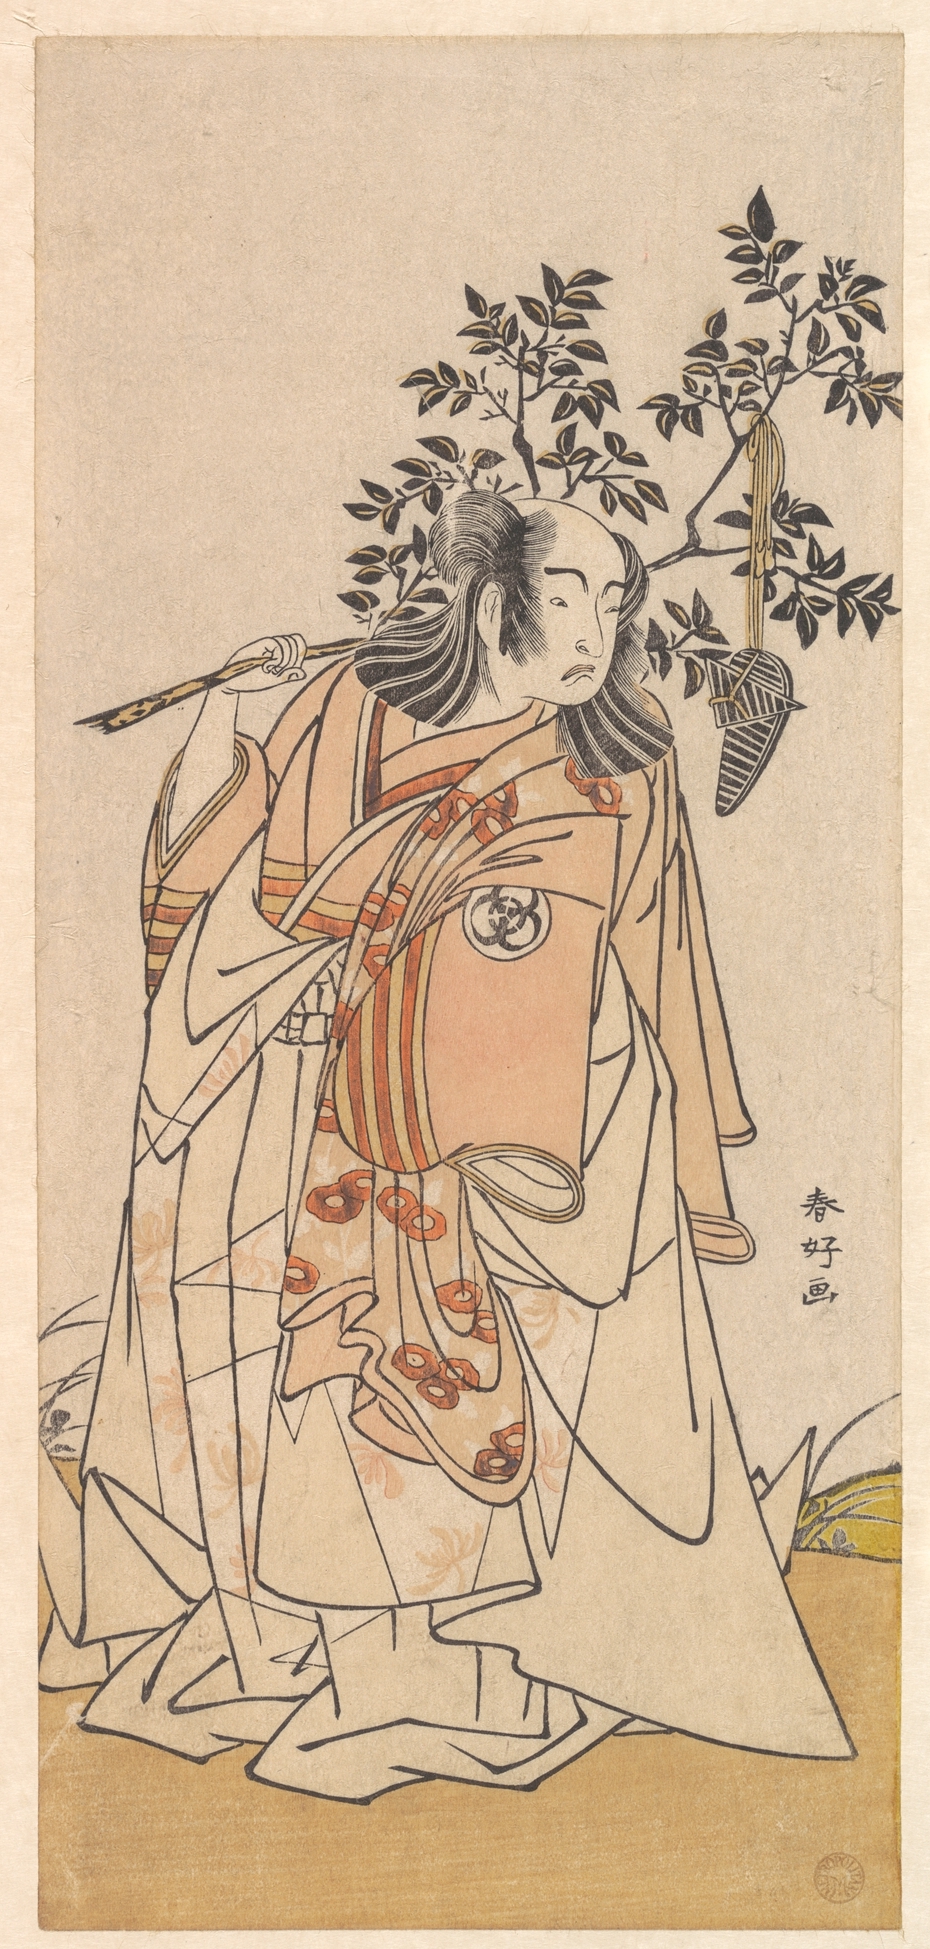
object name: print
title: The Actor Bando Mitsugoro I as a Man in Daimyo Attire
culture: japanese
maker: katsukawa shunkō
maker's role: artist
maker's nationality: japanese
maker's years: 1743-1812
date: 1778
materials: ink, paper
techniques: woodblock print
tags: men,actors